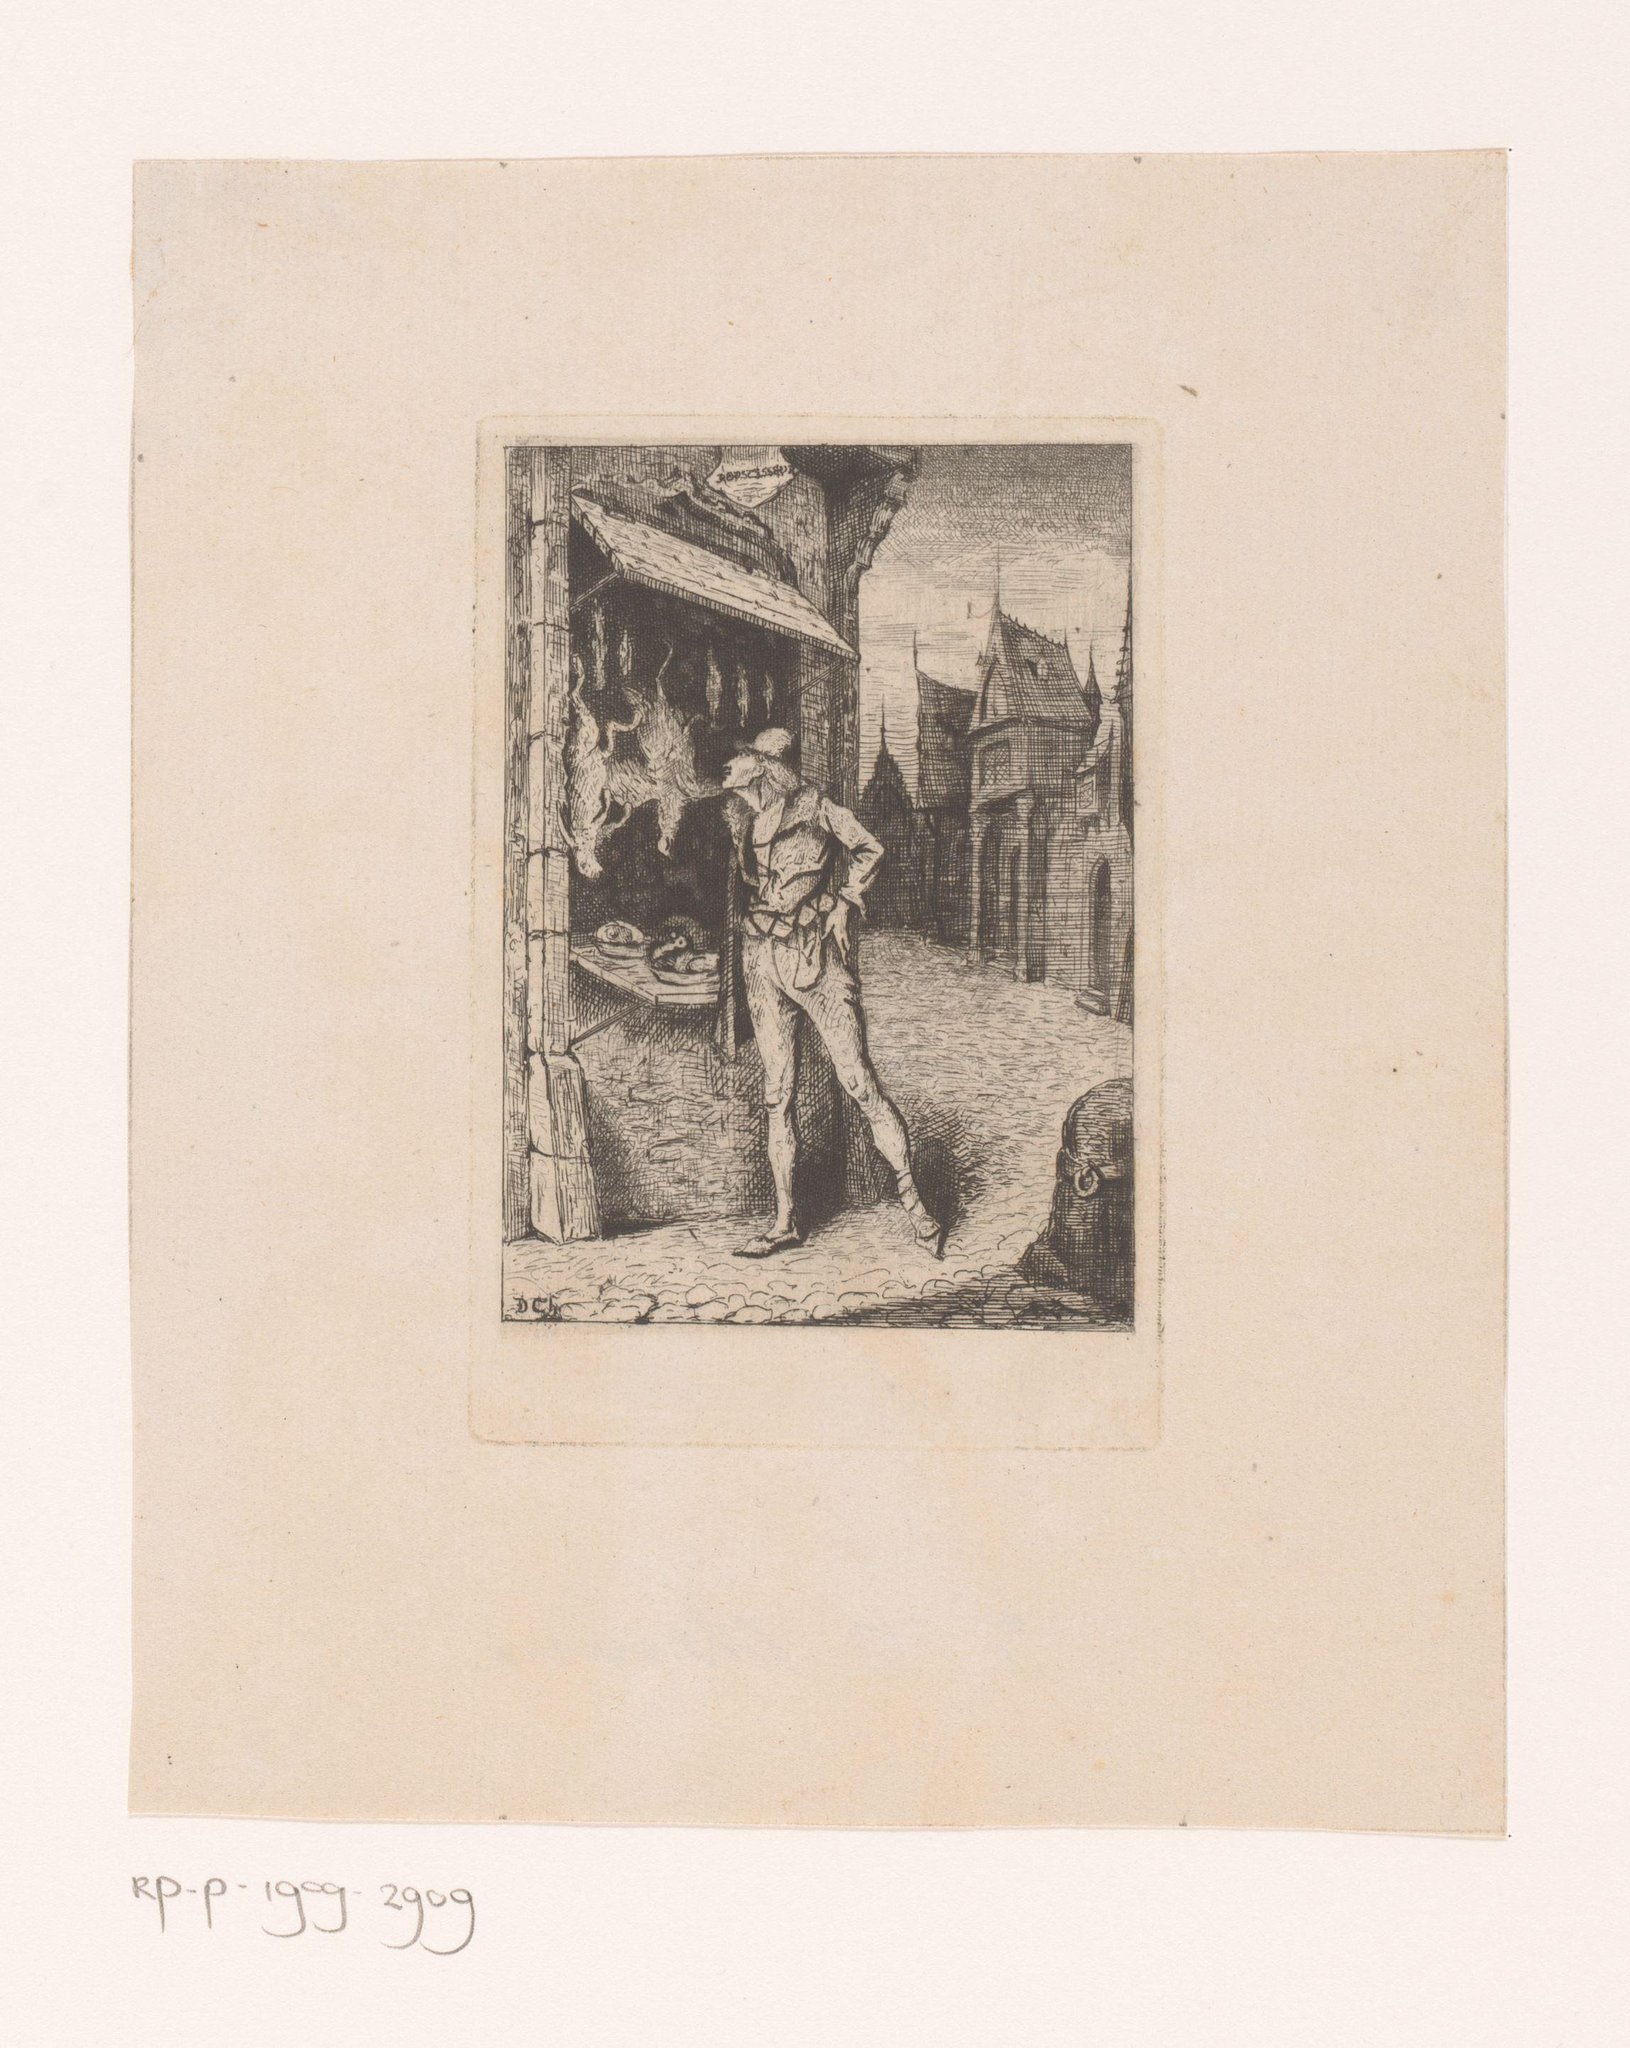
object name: print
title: Man in een middeleeuwse stad voor een slagerswinkel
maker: d. cheneux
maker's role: print maker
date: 1850-1909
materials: paper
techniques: drypoint, etching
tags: butcher, slaughterman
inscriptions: collector's mark: Lugt 2228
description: Sterfdatum prentmaker onbekend. Derhalve is voor bepaling van de rechten van dit object de verwervingsdatum aangehouden.